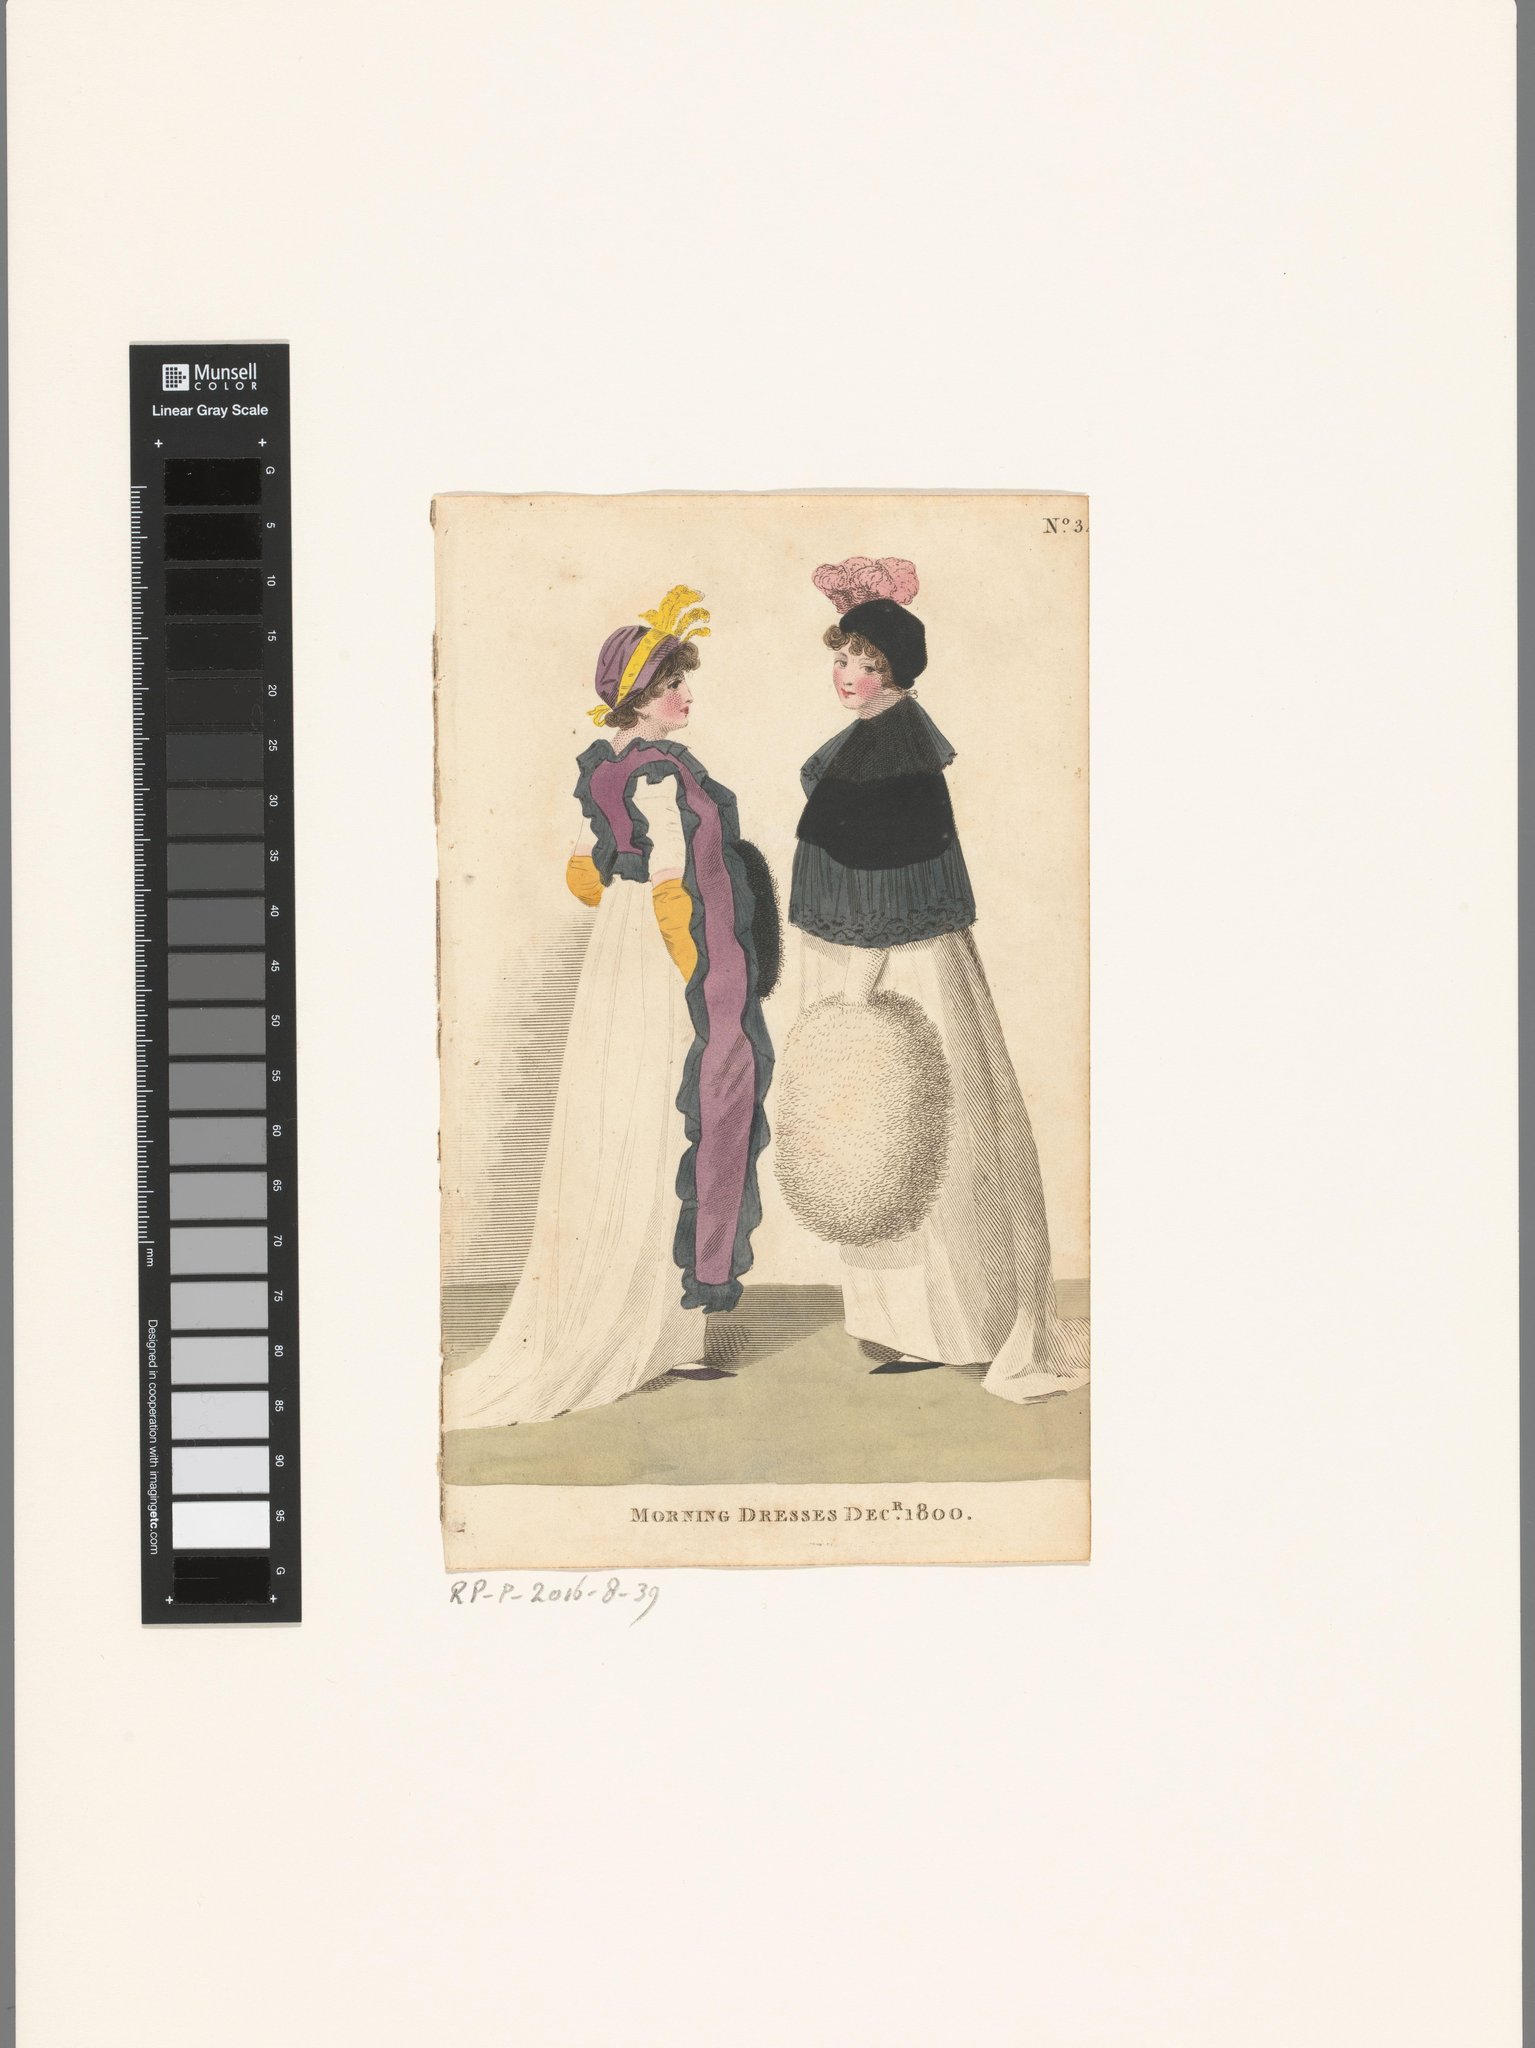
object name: fashion print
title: Magazine of Female Fashions of London and Paris, No. 3?, Morning Dresses, Dec. 1800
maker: richard phillips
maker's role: bookseller, publisher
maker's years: 1767-1840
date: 1800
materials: paper, ink, watercolor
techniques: etching, hand coloring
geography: london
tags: gloves, mittens (long gloves) (+ women's clothes), dress, gown: morning dress (+ women's clothes), head-gear: cap (+ women's clothes), fashion plates, muff (+ women's clothes)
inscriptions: collector's mark: Lugt 2228, : ‘Morning Dresses, Dec. 1800’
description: Twee Engelse ochtendjaponnen uit 1800. Mutsen met veren. De vrouw rechts draagt een grote mof.